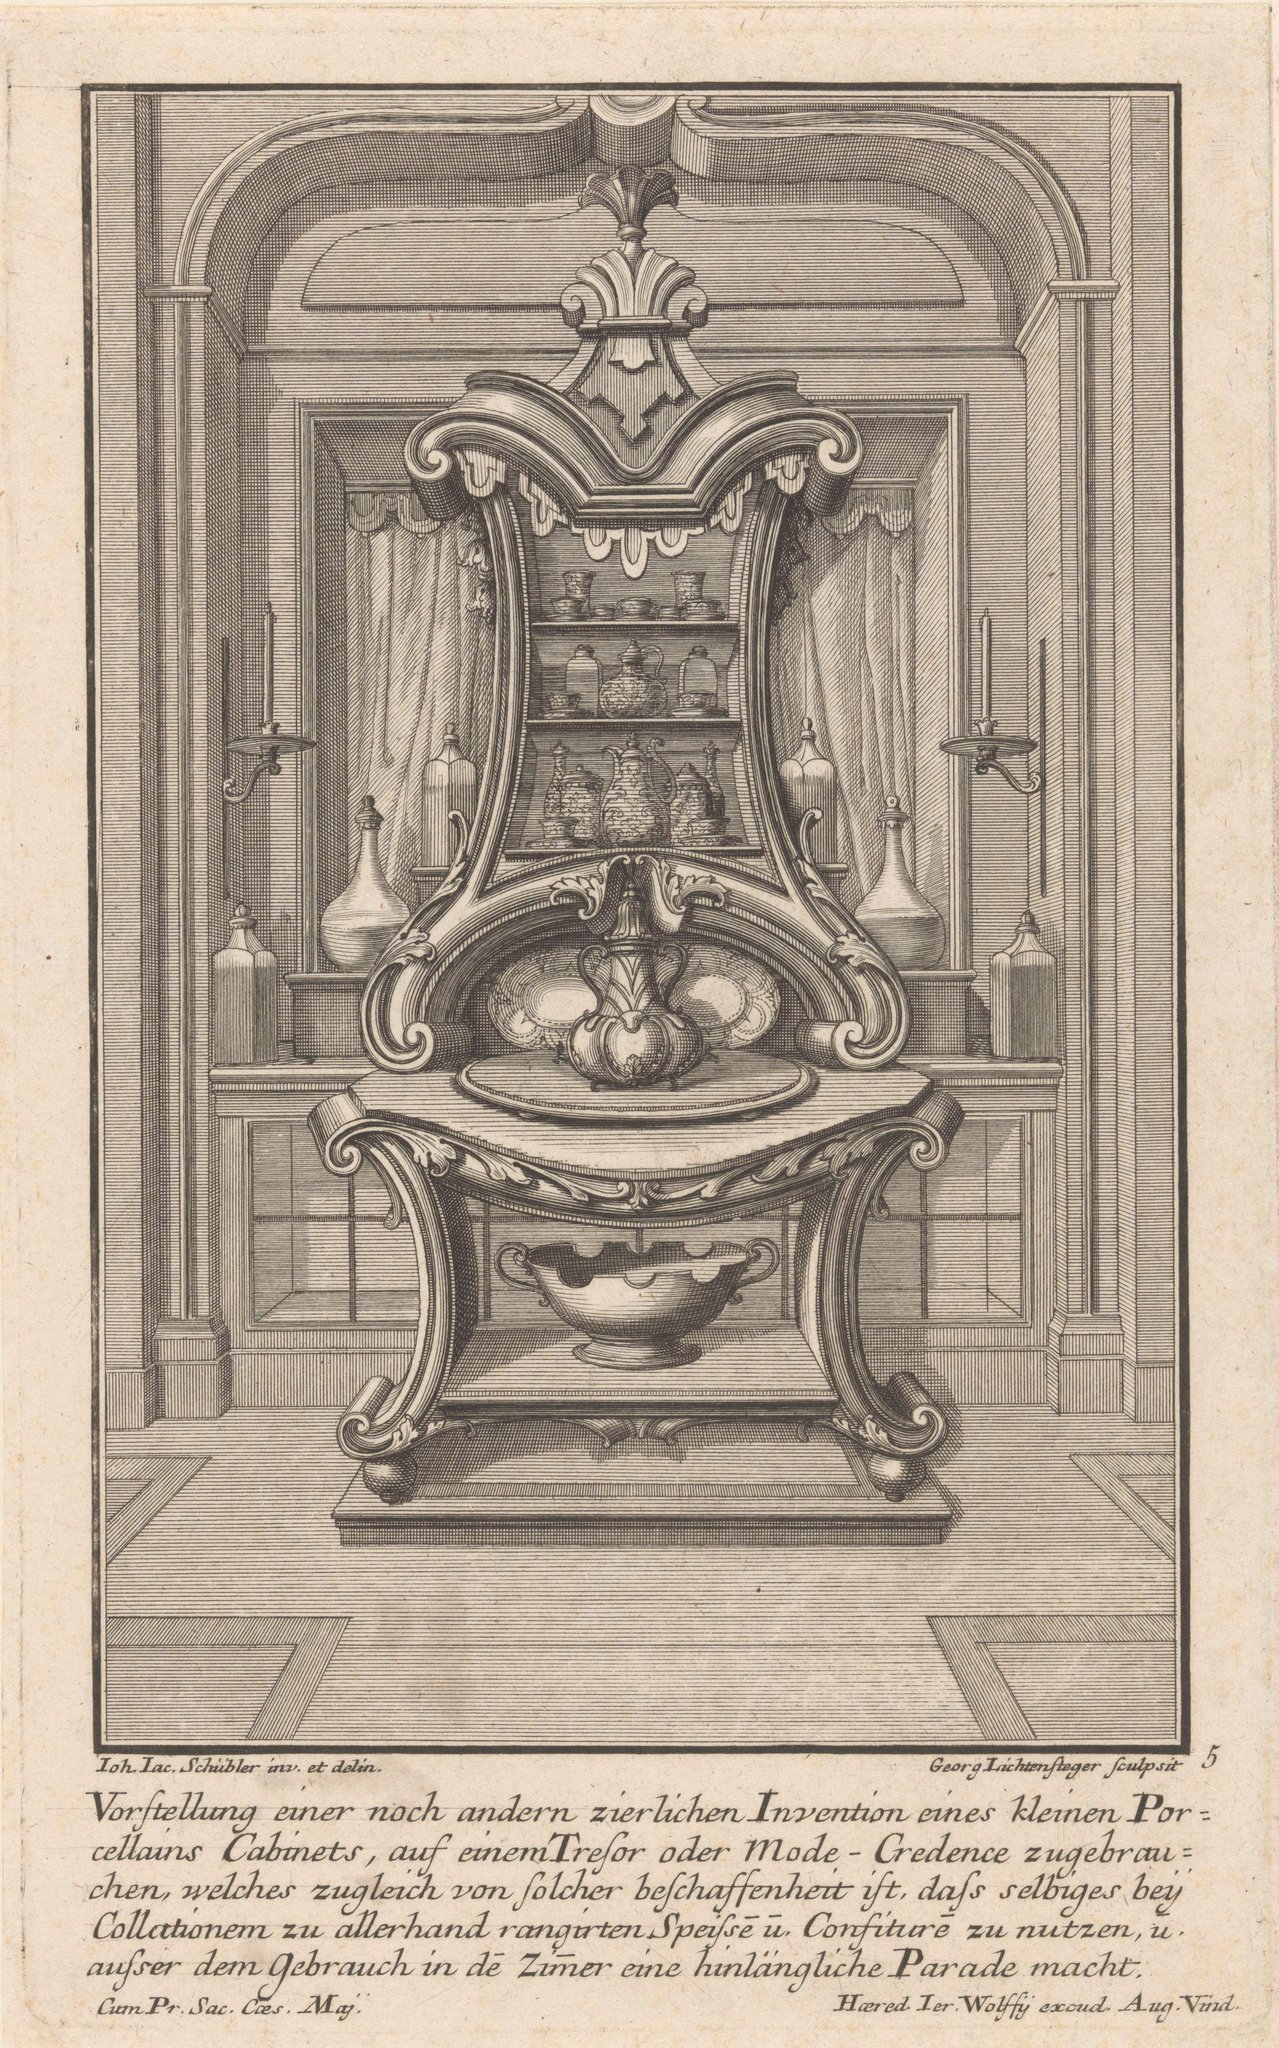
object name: ornament print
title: Credens voor nis met servies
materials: paper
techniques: engraving, etching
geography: augsburg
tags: shelves, rack, sideboard, 'concha' ~ architecture, (dinner-)service displayed on sideboard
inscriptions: collector's mark: Lugt 2228, collector's mark: Lugt 2760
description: Een geornamenteerde credens met servies staat voor een rechthoekige nis met kandelaars en flessen. In de ondermarge een vijfregelige Duitse tekst.